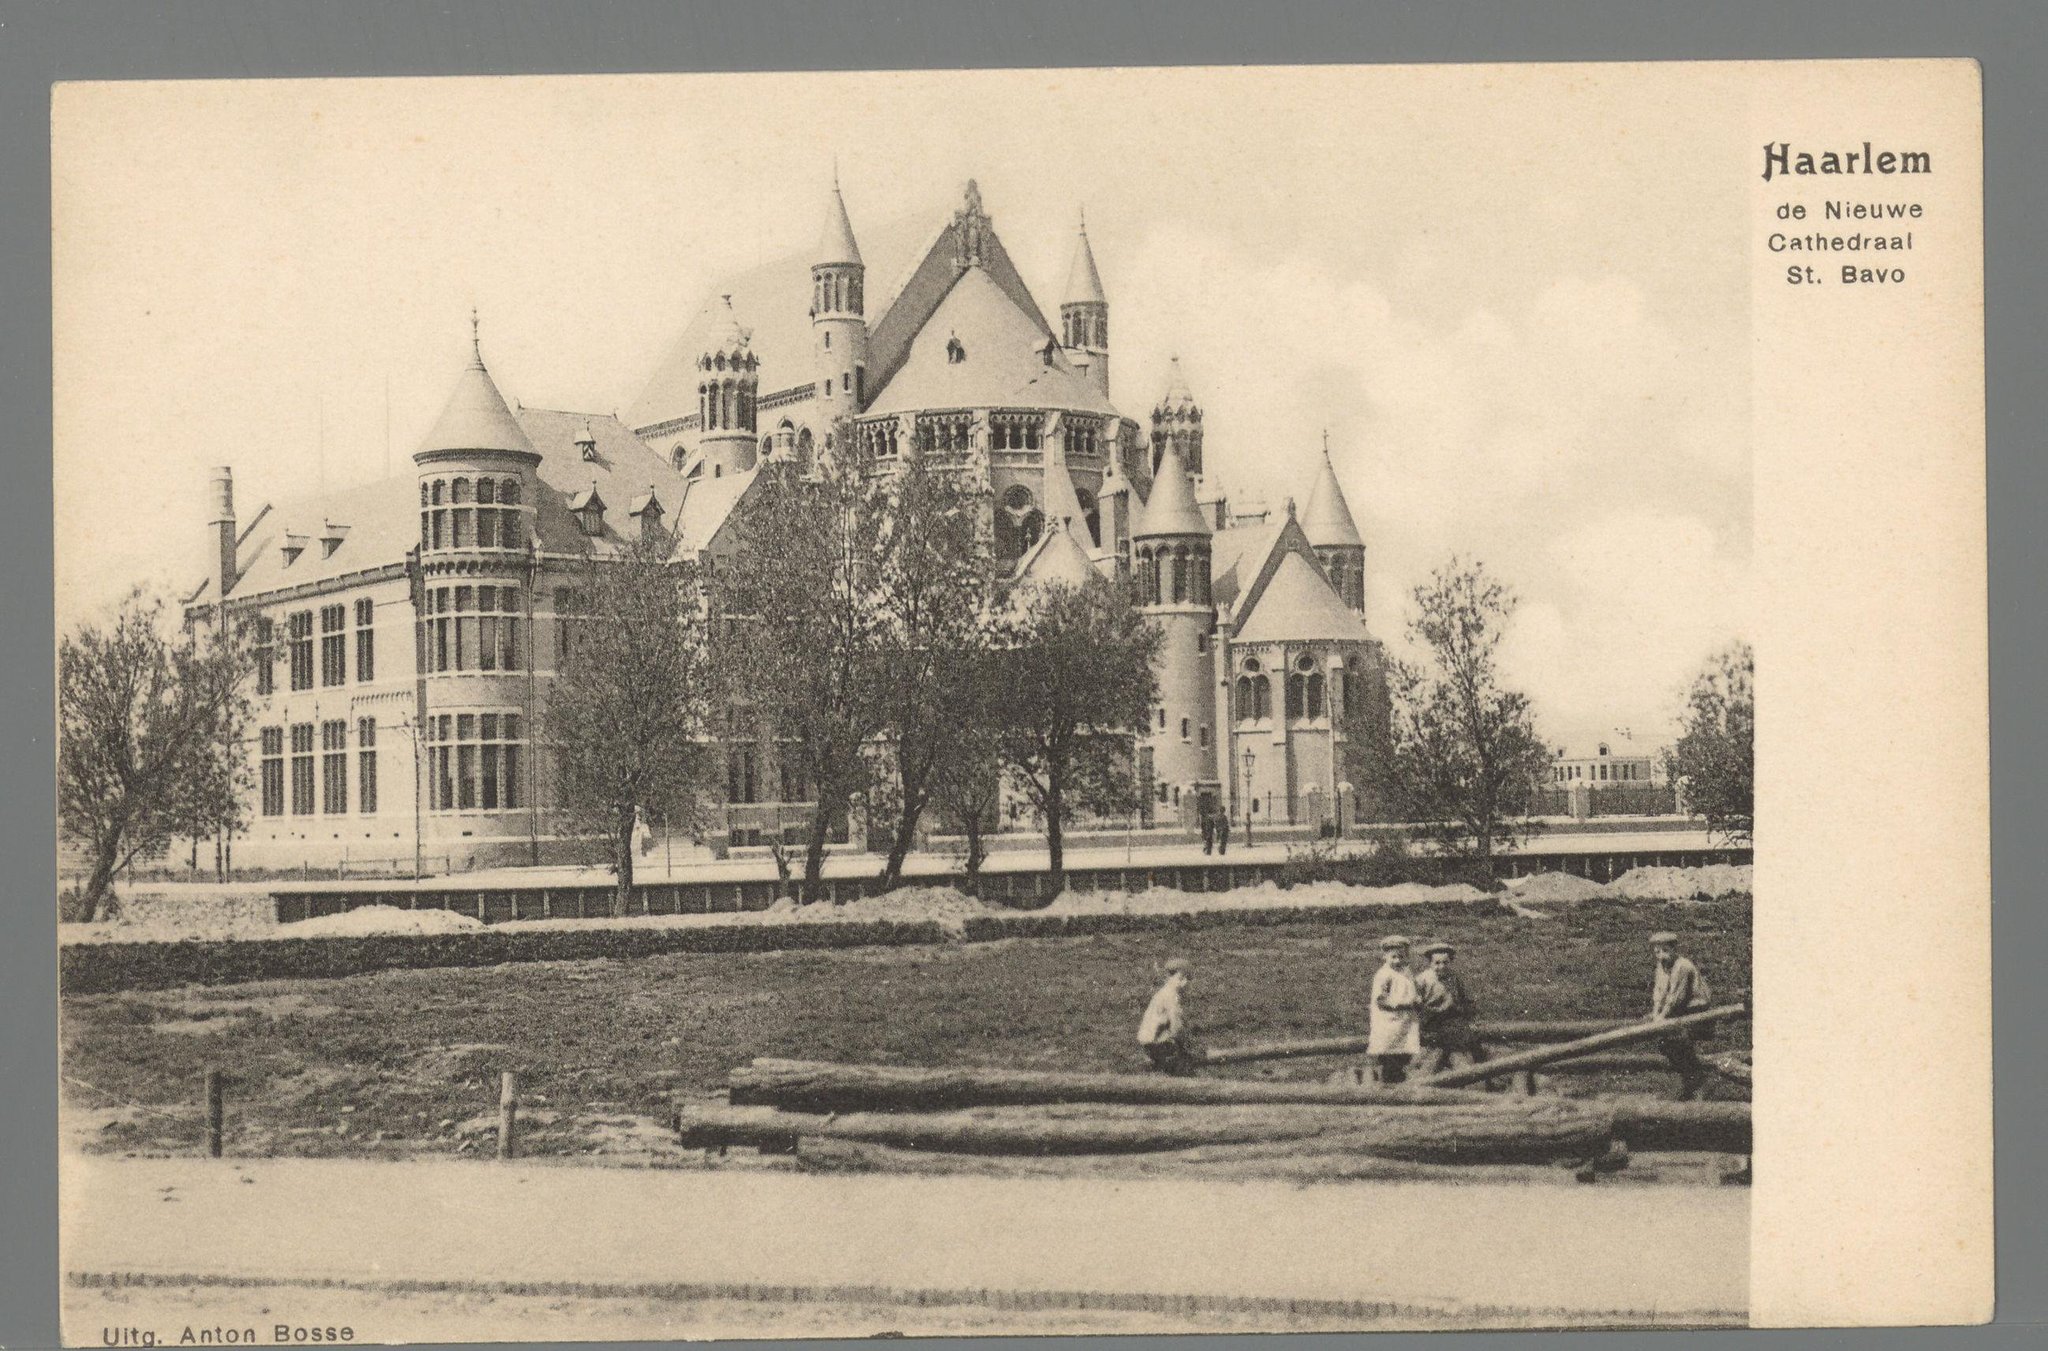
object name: photomechanical print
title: Haarlem de nieuwe Cathedraal St. Bavo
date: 1897-1905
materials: cardboard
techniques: photograph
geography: haarlem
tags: church (exterior), haarlem